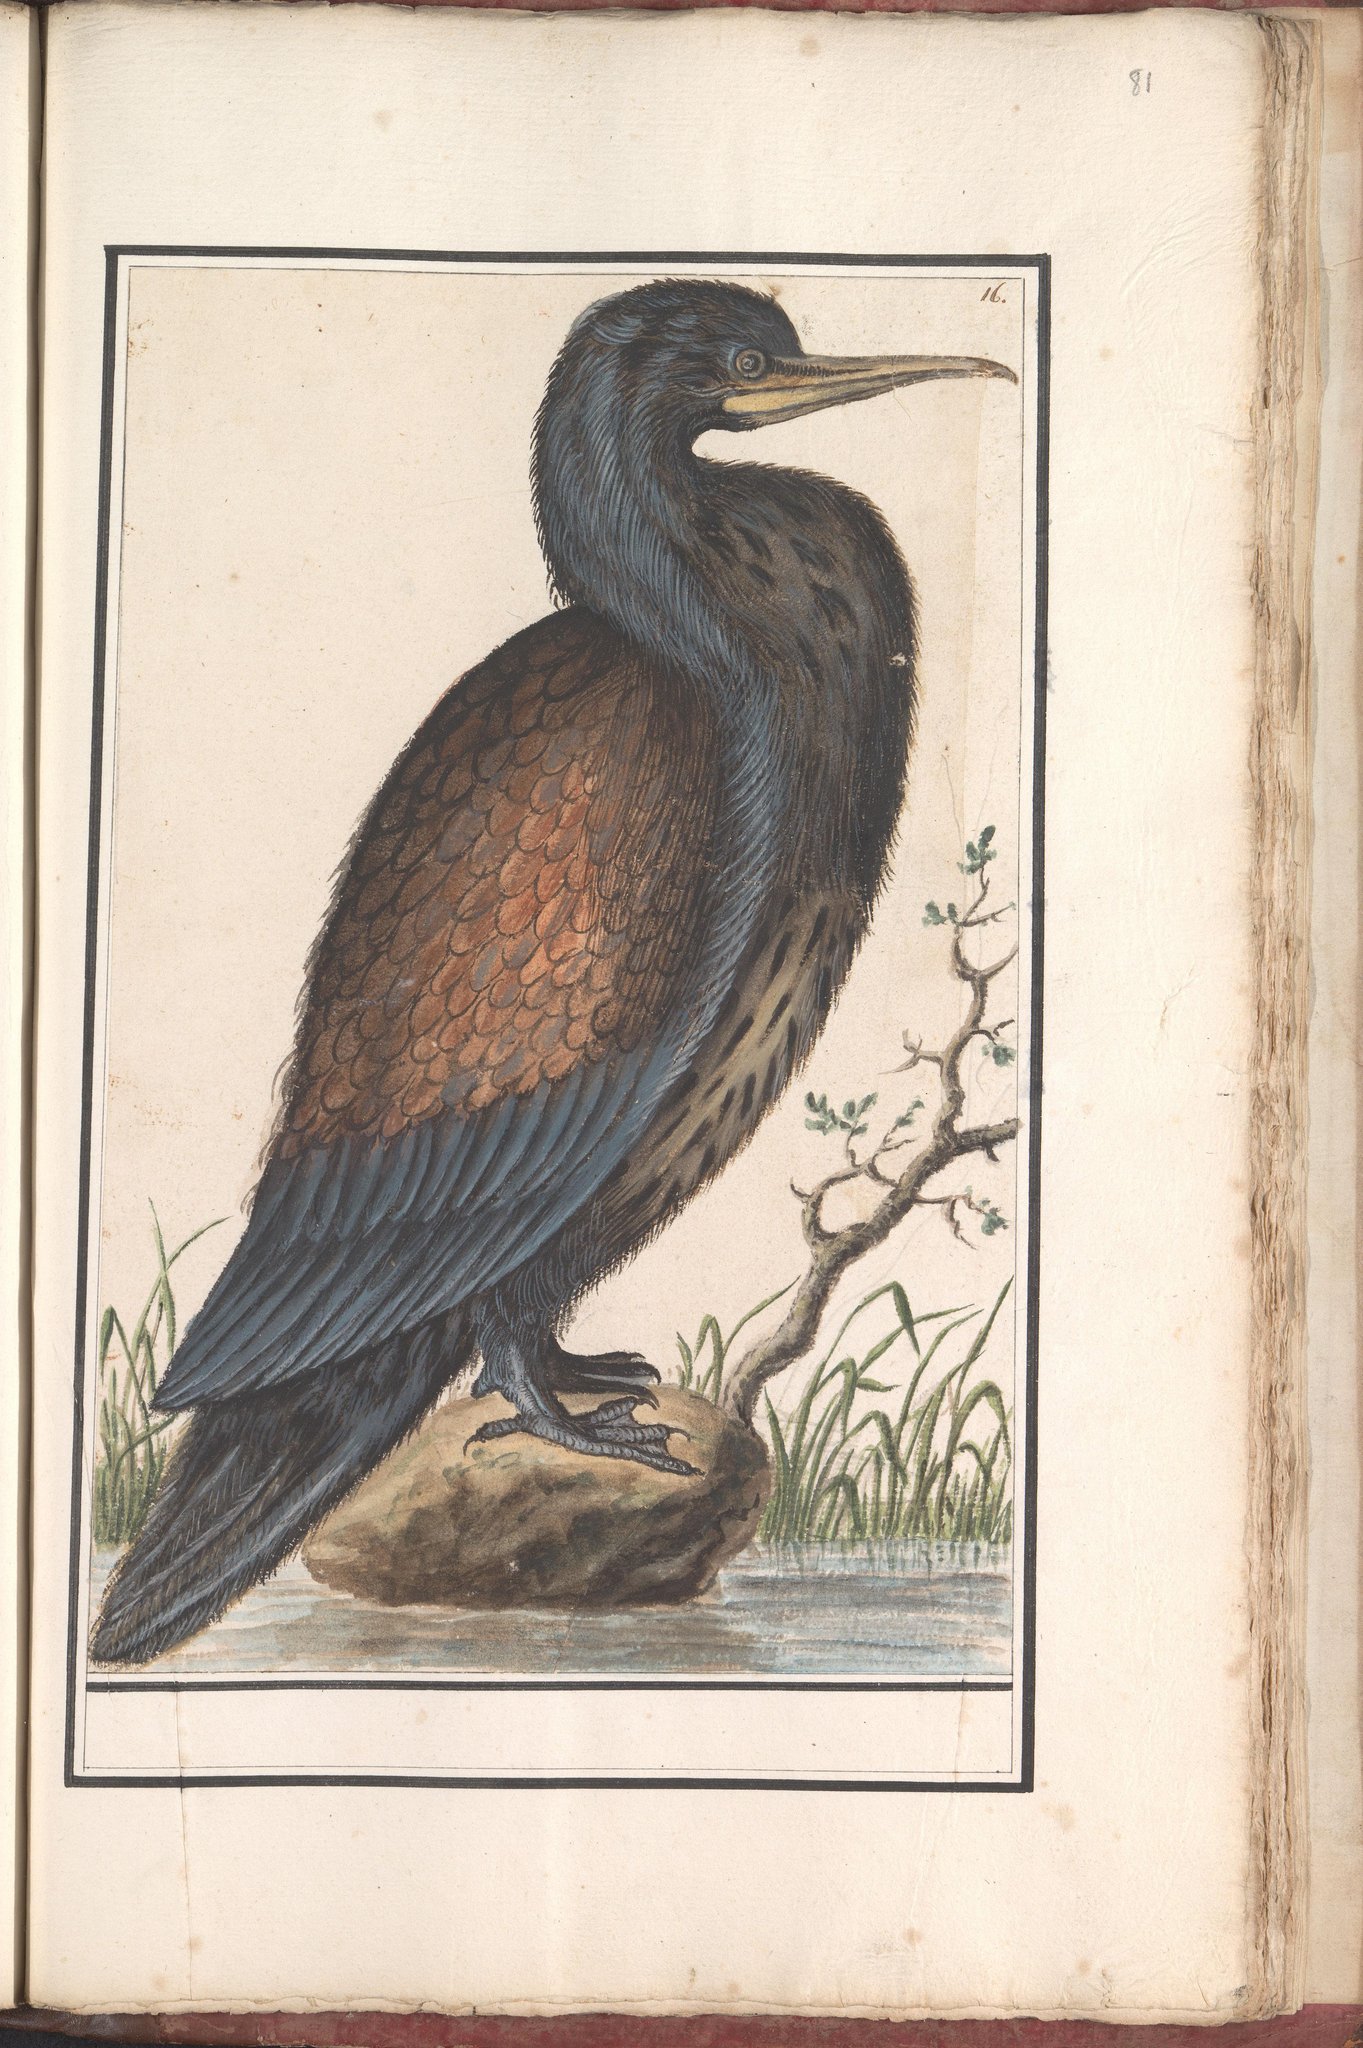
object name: drawing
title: Aalscholver (Phalacrocorax carbo)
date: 1596-1610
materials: chalk, paint, ink, paper, pencil, watercolor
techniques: brush, pen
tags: water-birds: cormorant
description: Aalscholver. Genummerd rechtsboven: 16. Onderdeel van het derde album met tekeningen van vogels. Vijfde van twaalf albums met tekeningen van dieren, vogels en planten bekend rond 1600, gemaakt in opdracht van keizer Rudolf II. Met toelichting in Nederlands, Latijn en Frans.